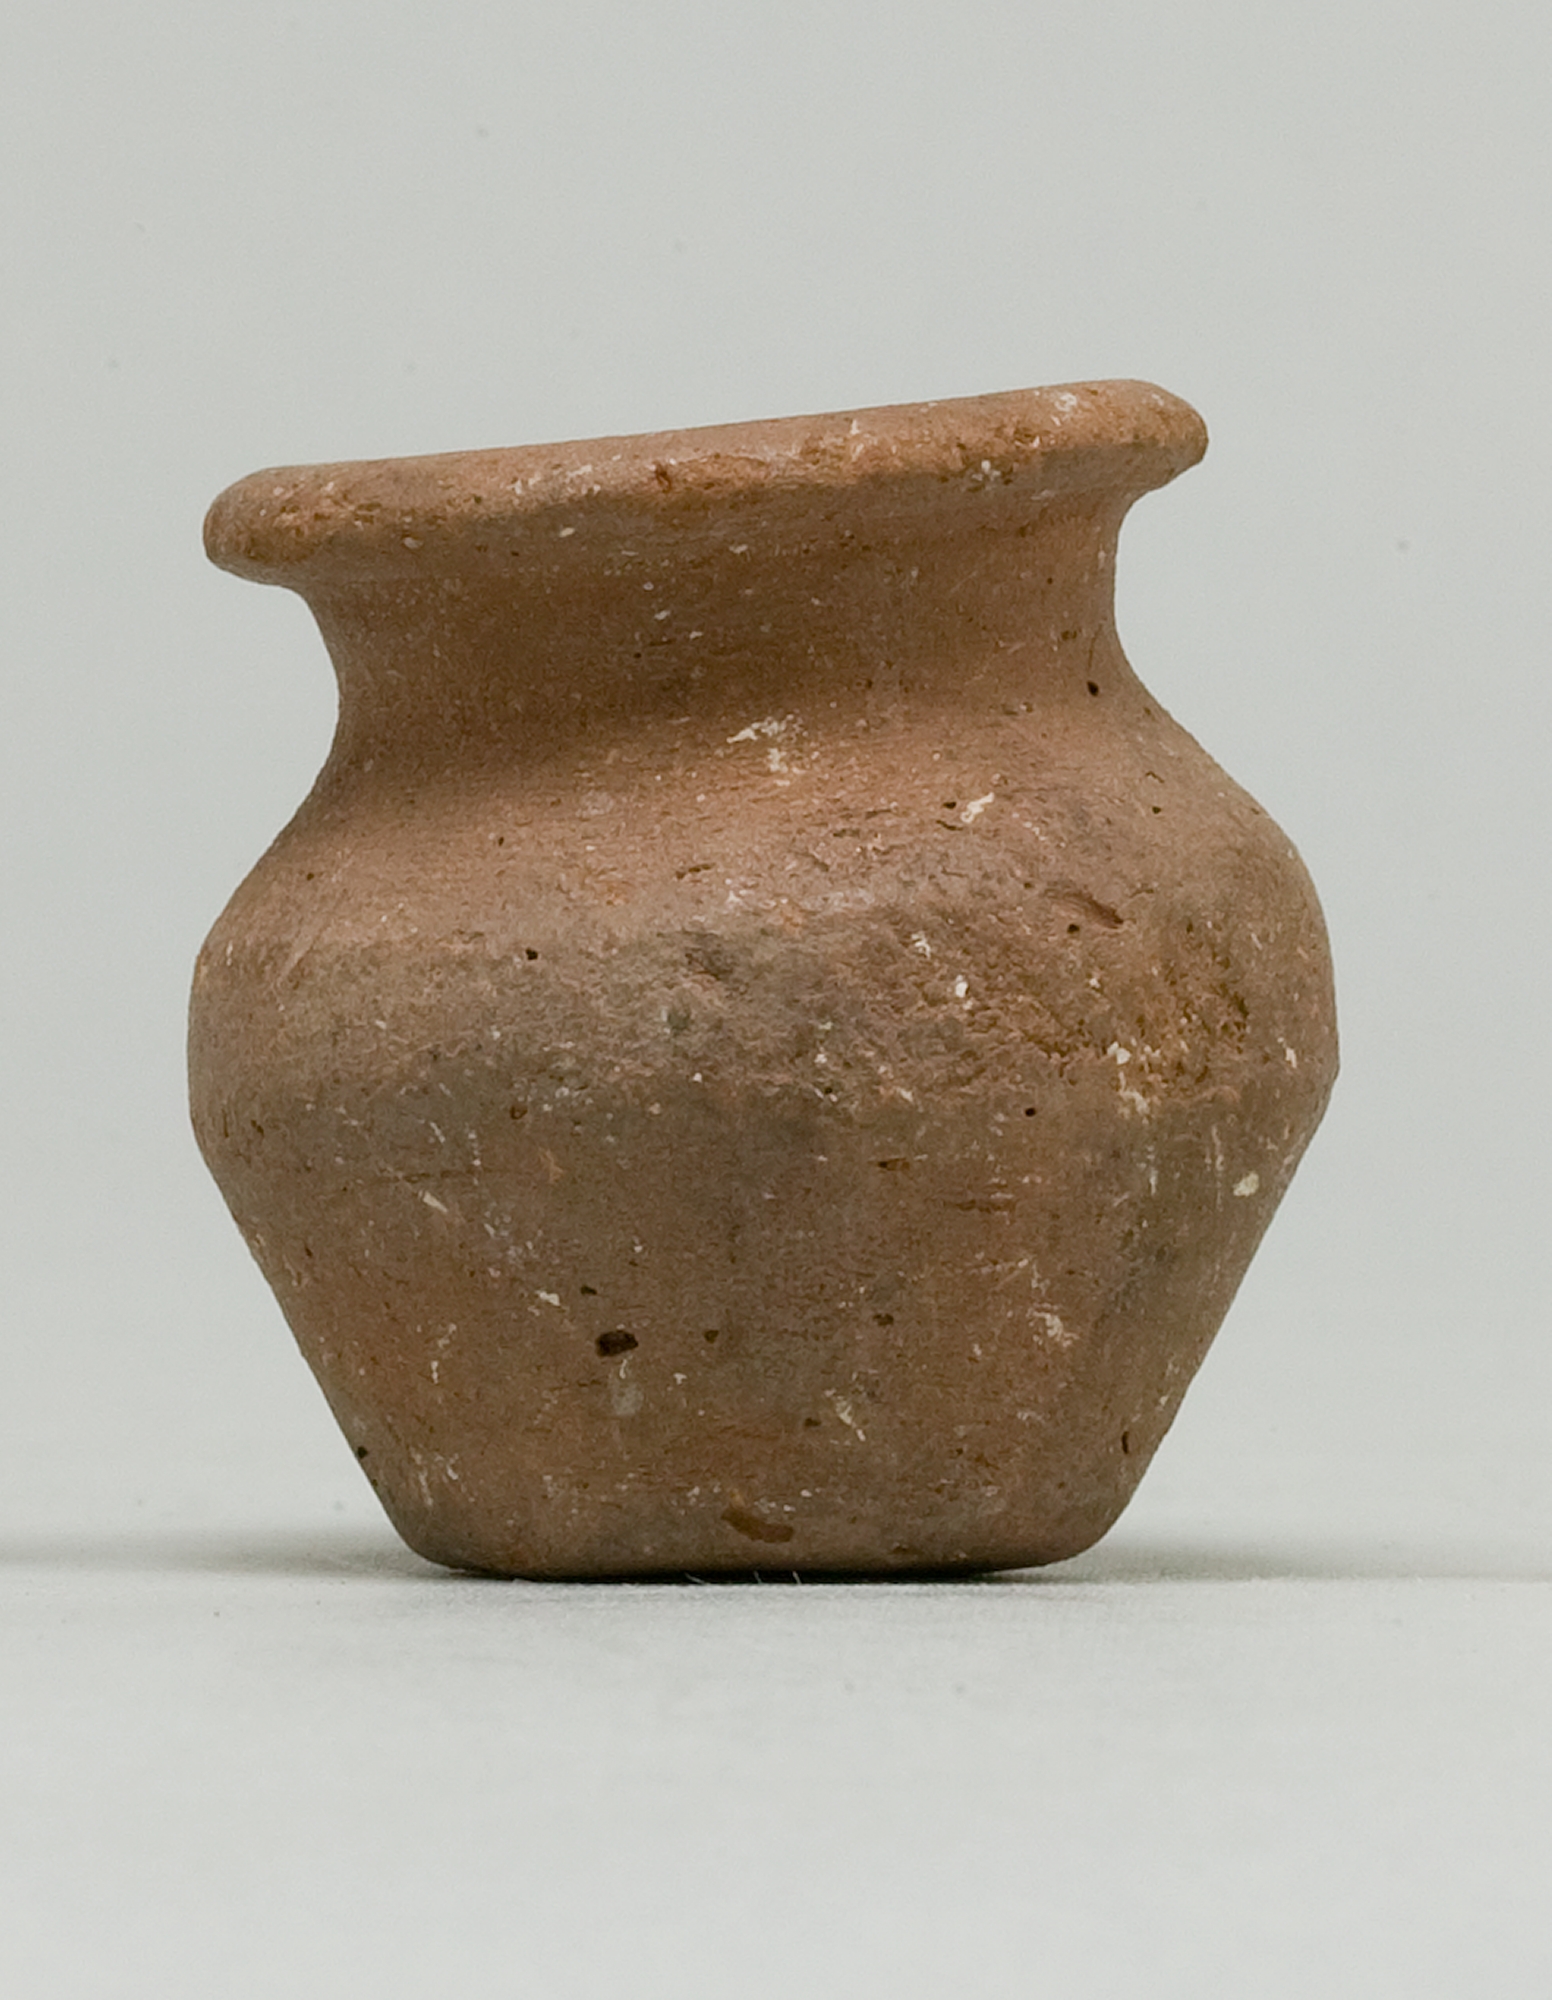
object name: kohl jar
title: Kohl pot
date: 2030-1640 BCE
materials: pottery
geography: egypt